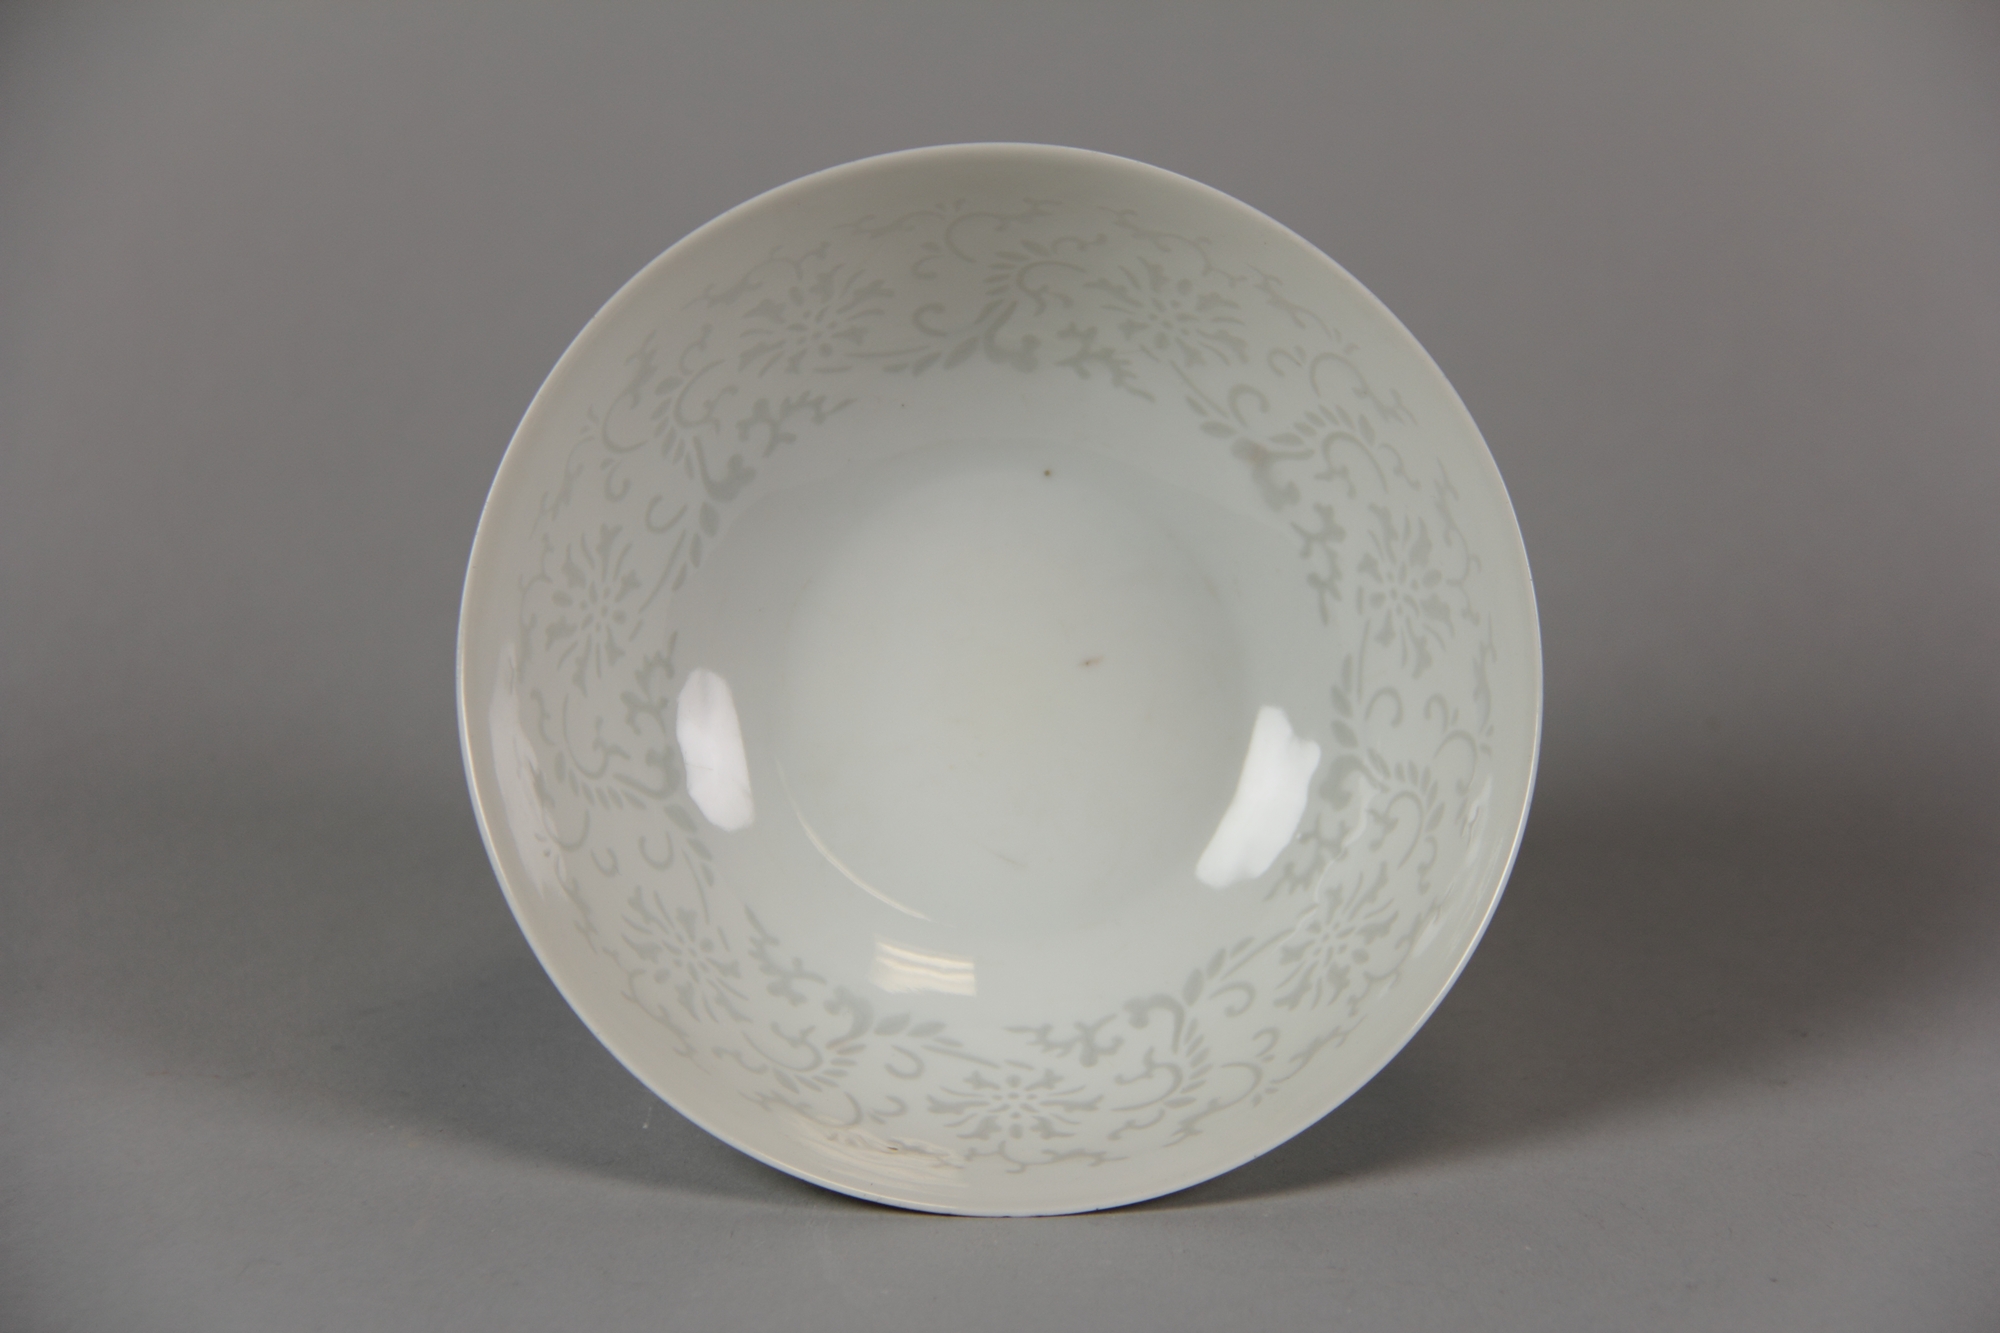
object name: cup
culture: chinese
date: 1736-1795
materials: porcelain